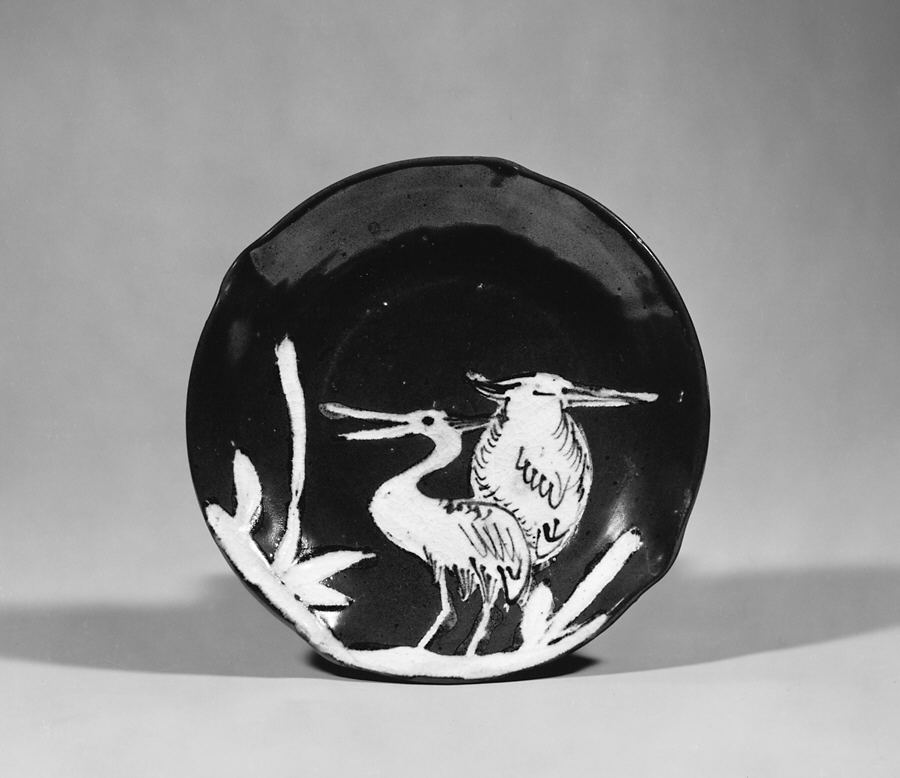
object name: plate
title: Plate with Design of Two Cranes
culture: japanese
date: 1615-1868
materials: glaze, iron, porcelain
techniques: underglaze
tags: cranes